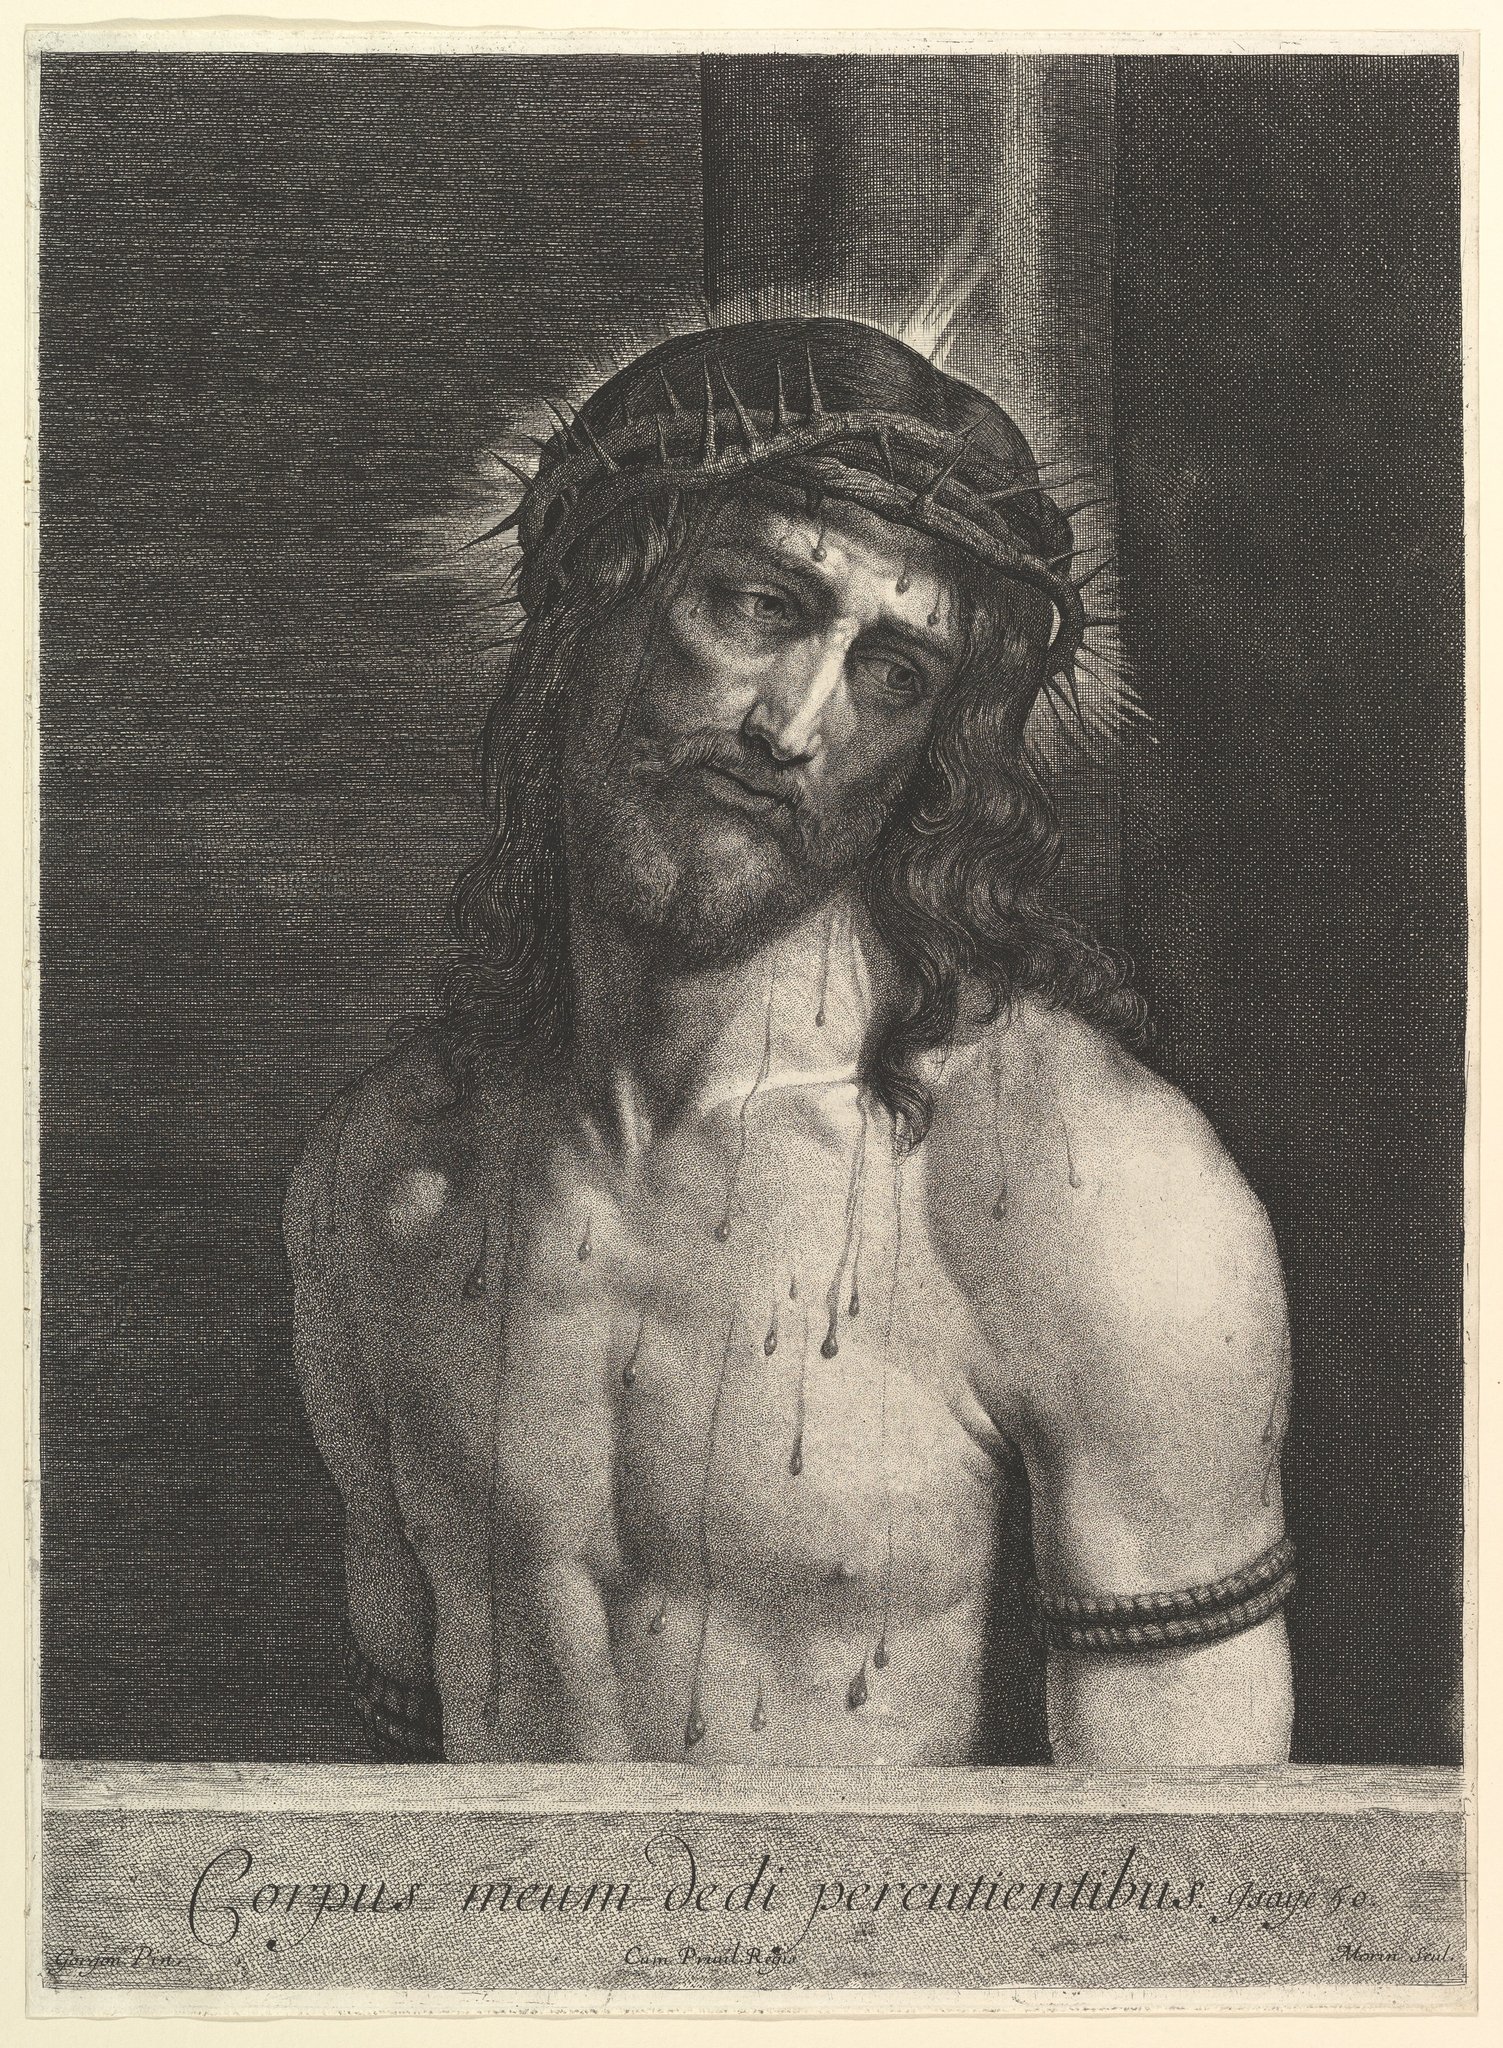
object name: print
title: Le Christ a la colonne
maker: jean morin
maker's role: artist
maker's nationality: french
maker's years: 1605-1650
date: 1605-1650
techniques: etching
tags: christ